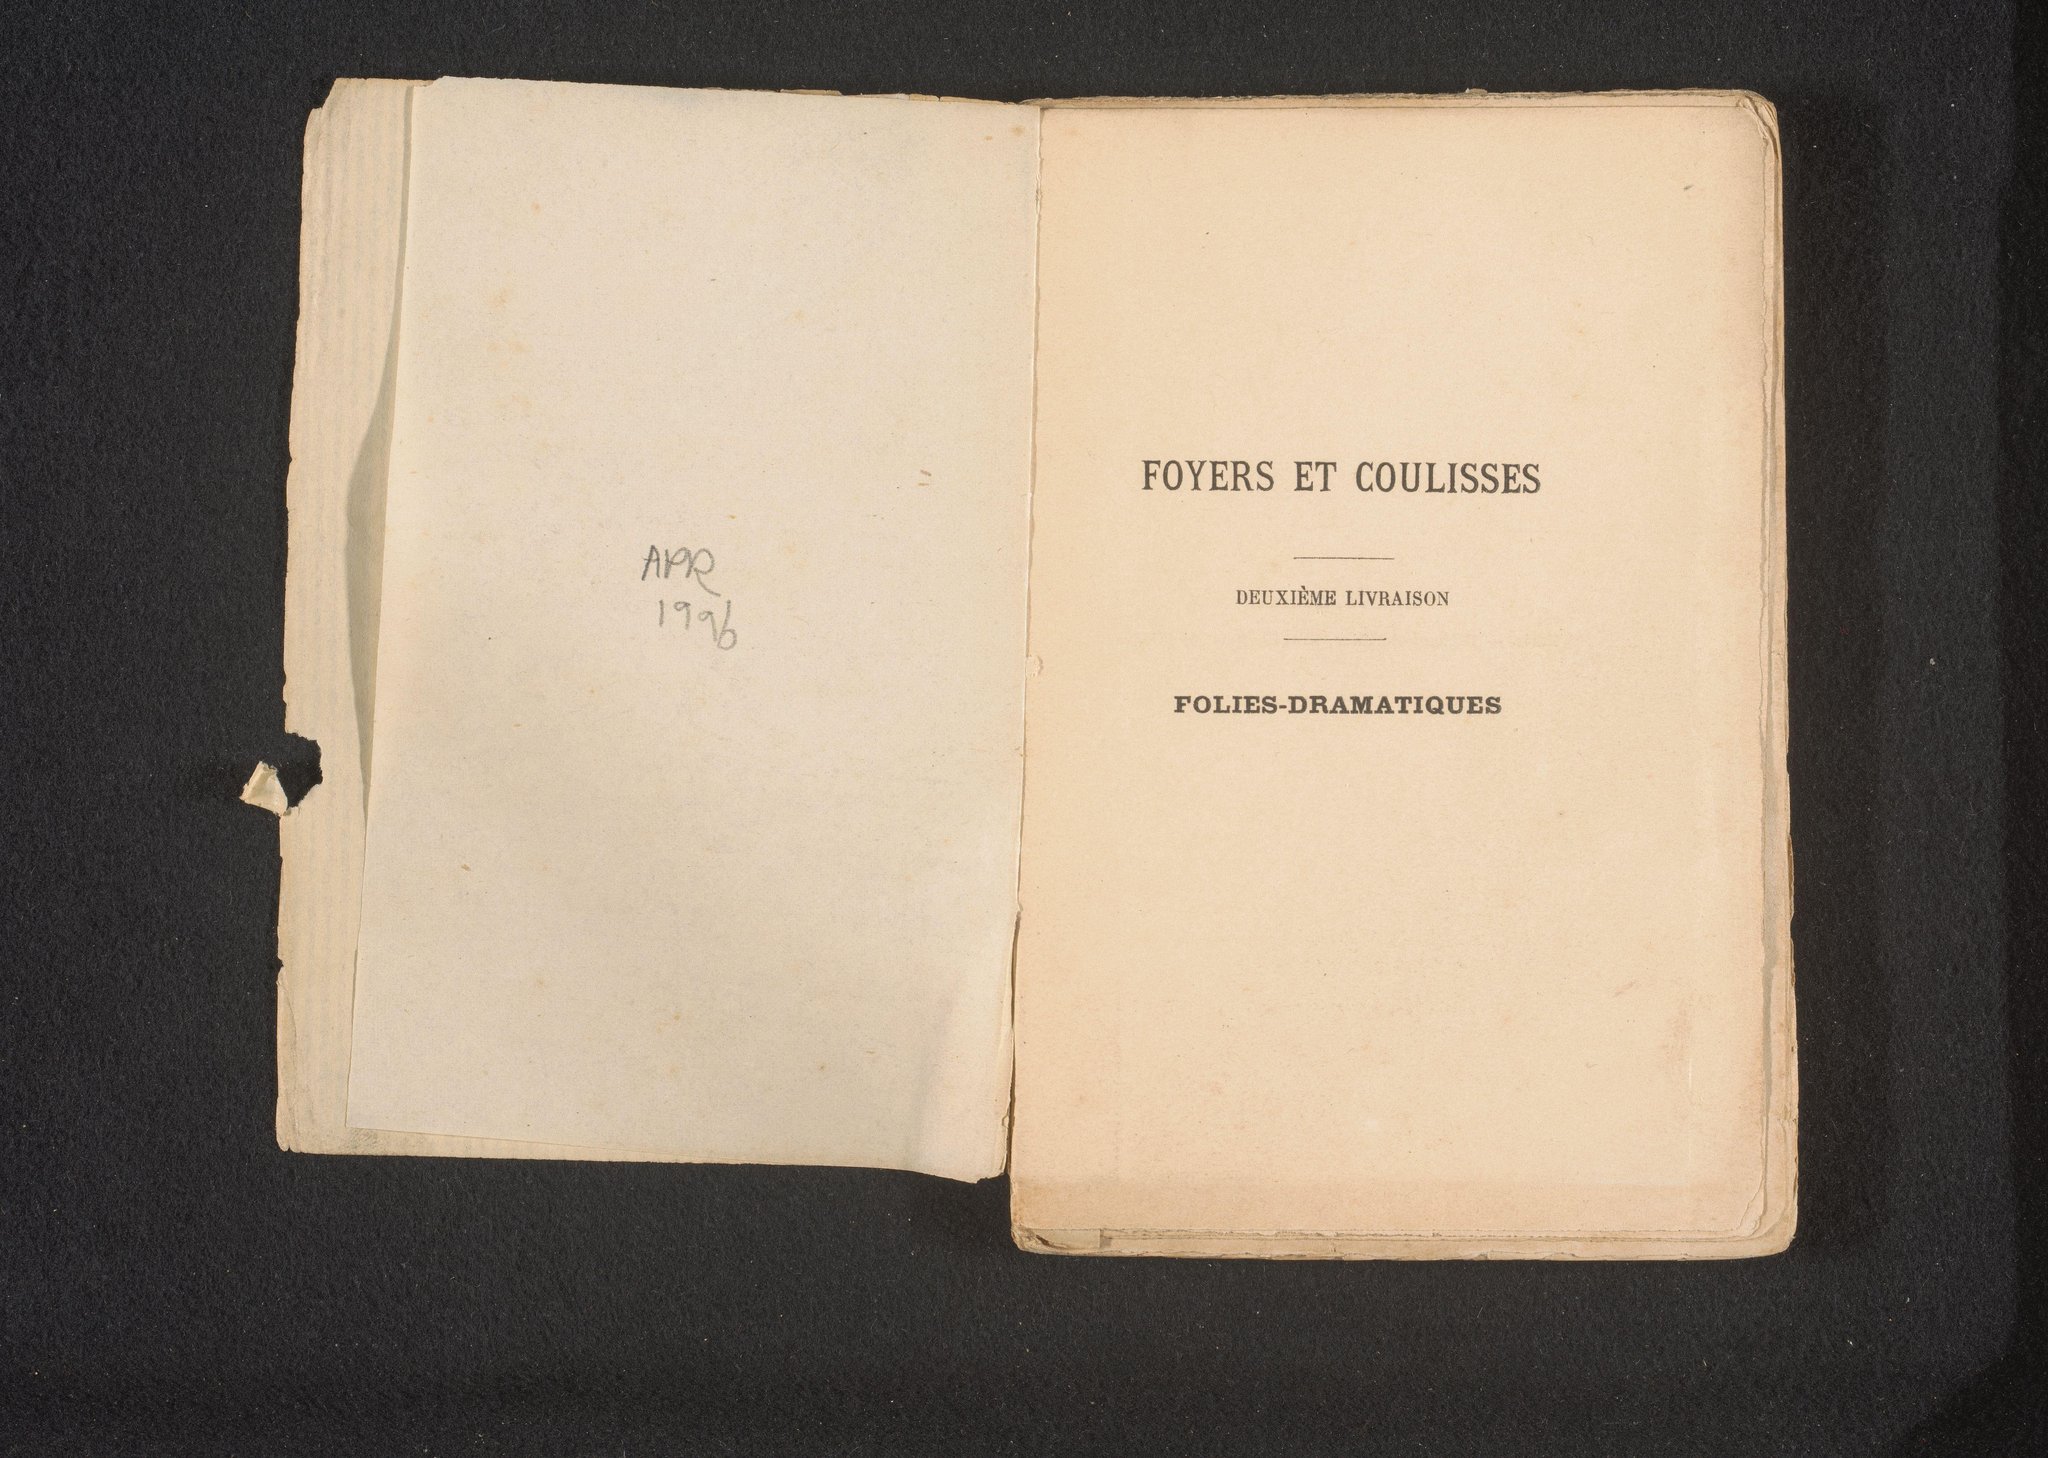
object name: book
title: Foyers et coulisses : histoire anecdotique des théatres de Paris : Folies-dramatiques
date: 1873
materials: paper, photographic support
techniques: albumen print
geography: paris